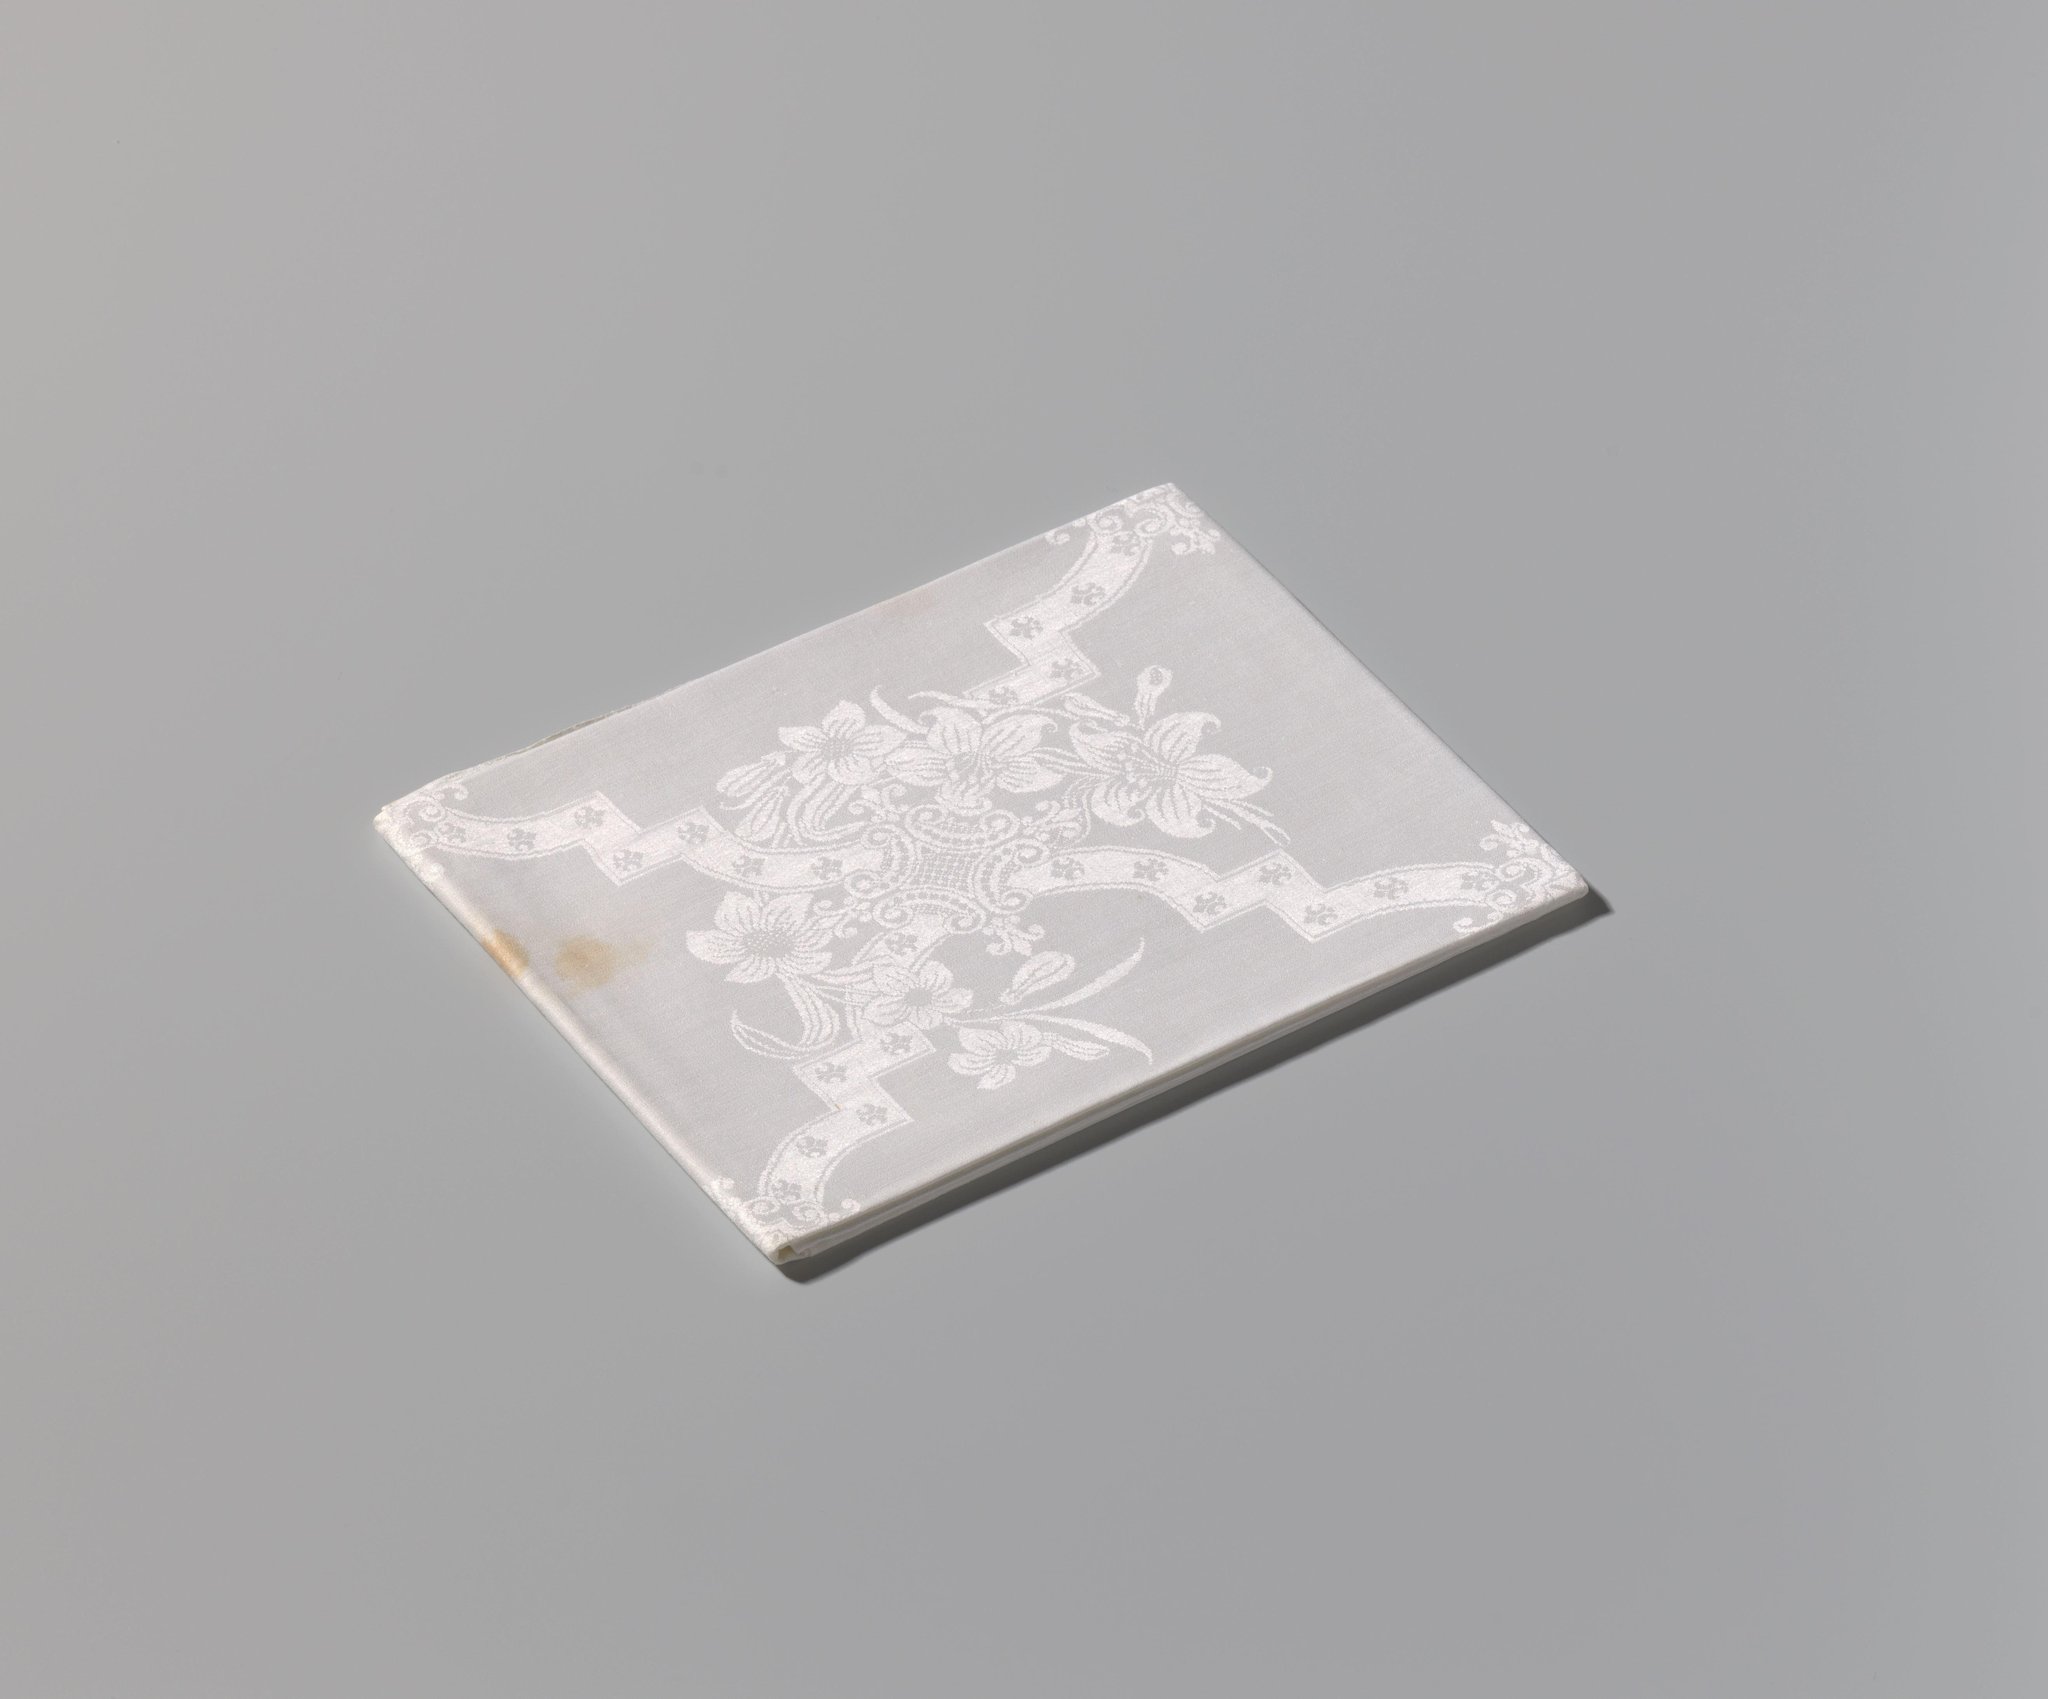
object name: napkin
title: Servet met fleurs de lys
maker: Anonymous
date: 1700-1710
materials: linen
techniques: damask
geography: dresden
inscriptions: mark: ‘24’, mark: ‘BLS’, label: ‘R.M. A'dam’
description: Servet van linnendamast met fleurs de lys. Slingerende banden vormen in de hoogte gerekte velden. De banden bestaan uit rechte en ronde delen, gevuld met kleine fleurs de lys; op de raakpunten een slingerende tak met leliën. De rand, alleen aan de buitenzijde omlijnd met fijne zigzagzomen en rolwerk met rastervulling, vertoont dicht aaneengesloten bloemboeketten, in de hoeken naar het midden gericht en voortkomend uit een draagstuk, waarop een fleur de lys. Rondom: blokkenrand.